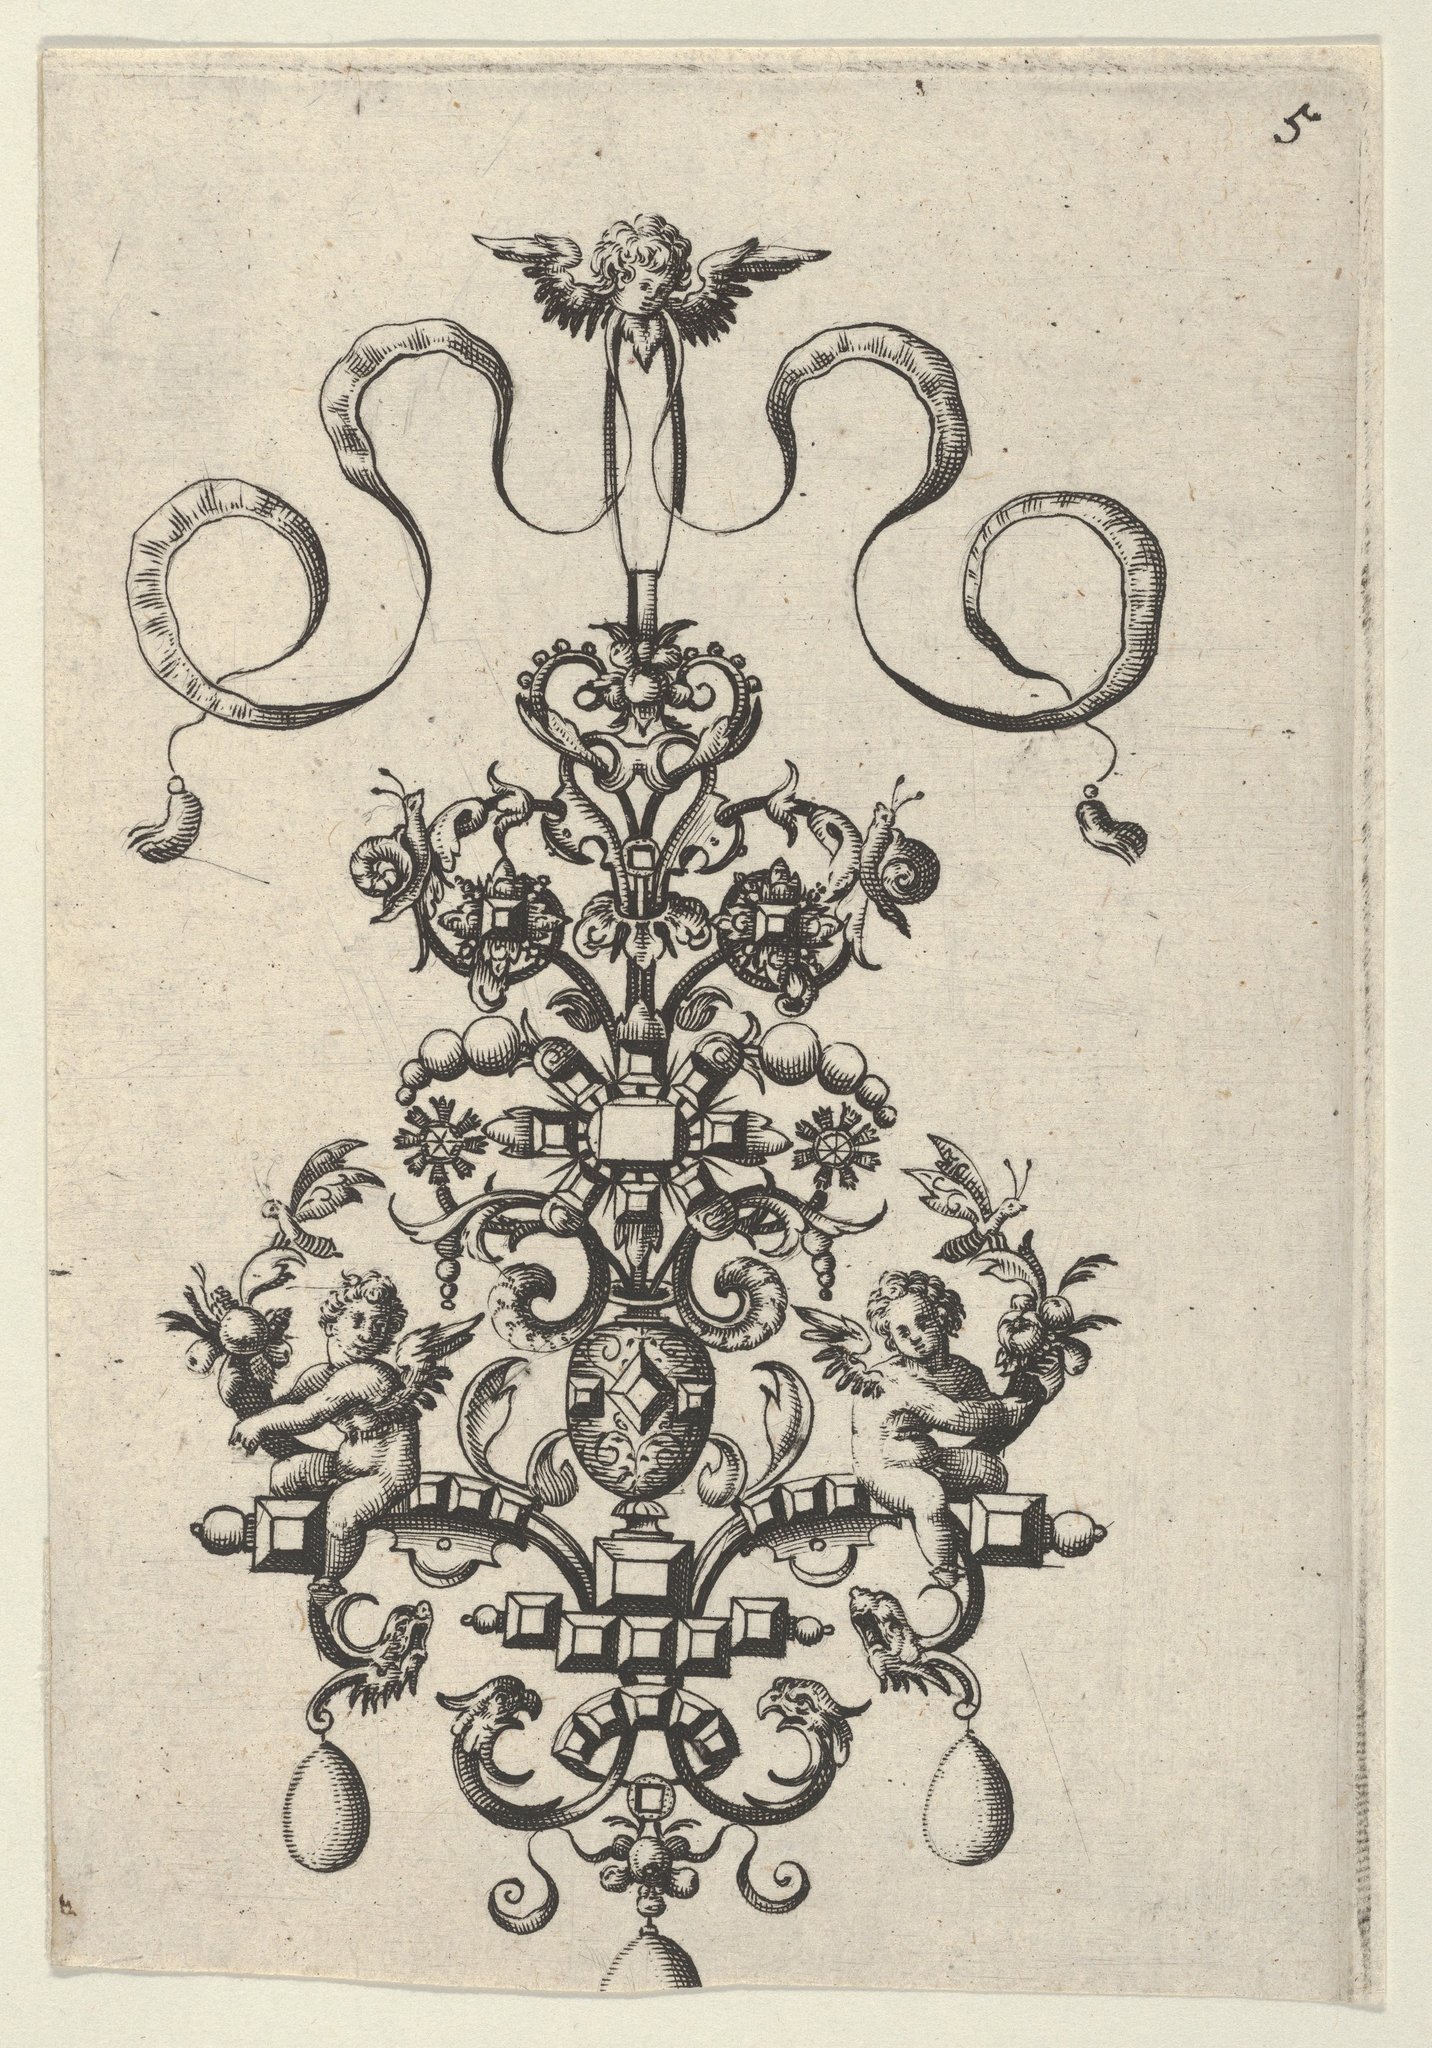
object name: print ornament architecture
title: Reverse Copy of Design for a Pendant, from Ars His Myronis Nobilis Effingitus Pagellulis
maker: paul birckenhultz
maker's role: artist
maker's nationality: german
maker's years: 1561-1639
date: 1600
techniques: engraving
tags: insects